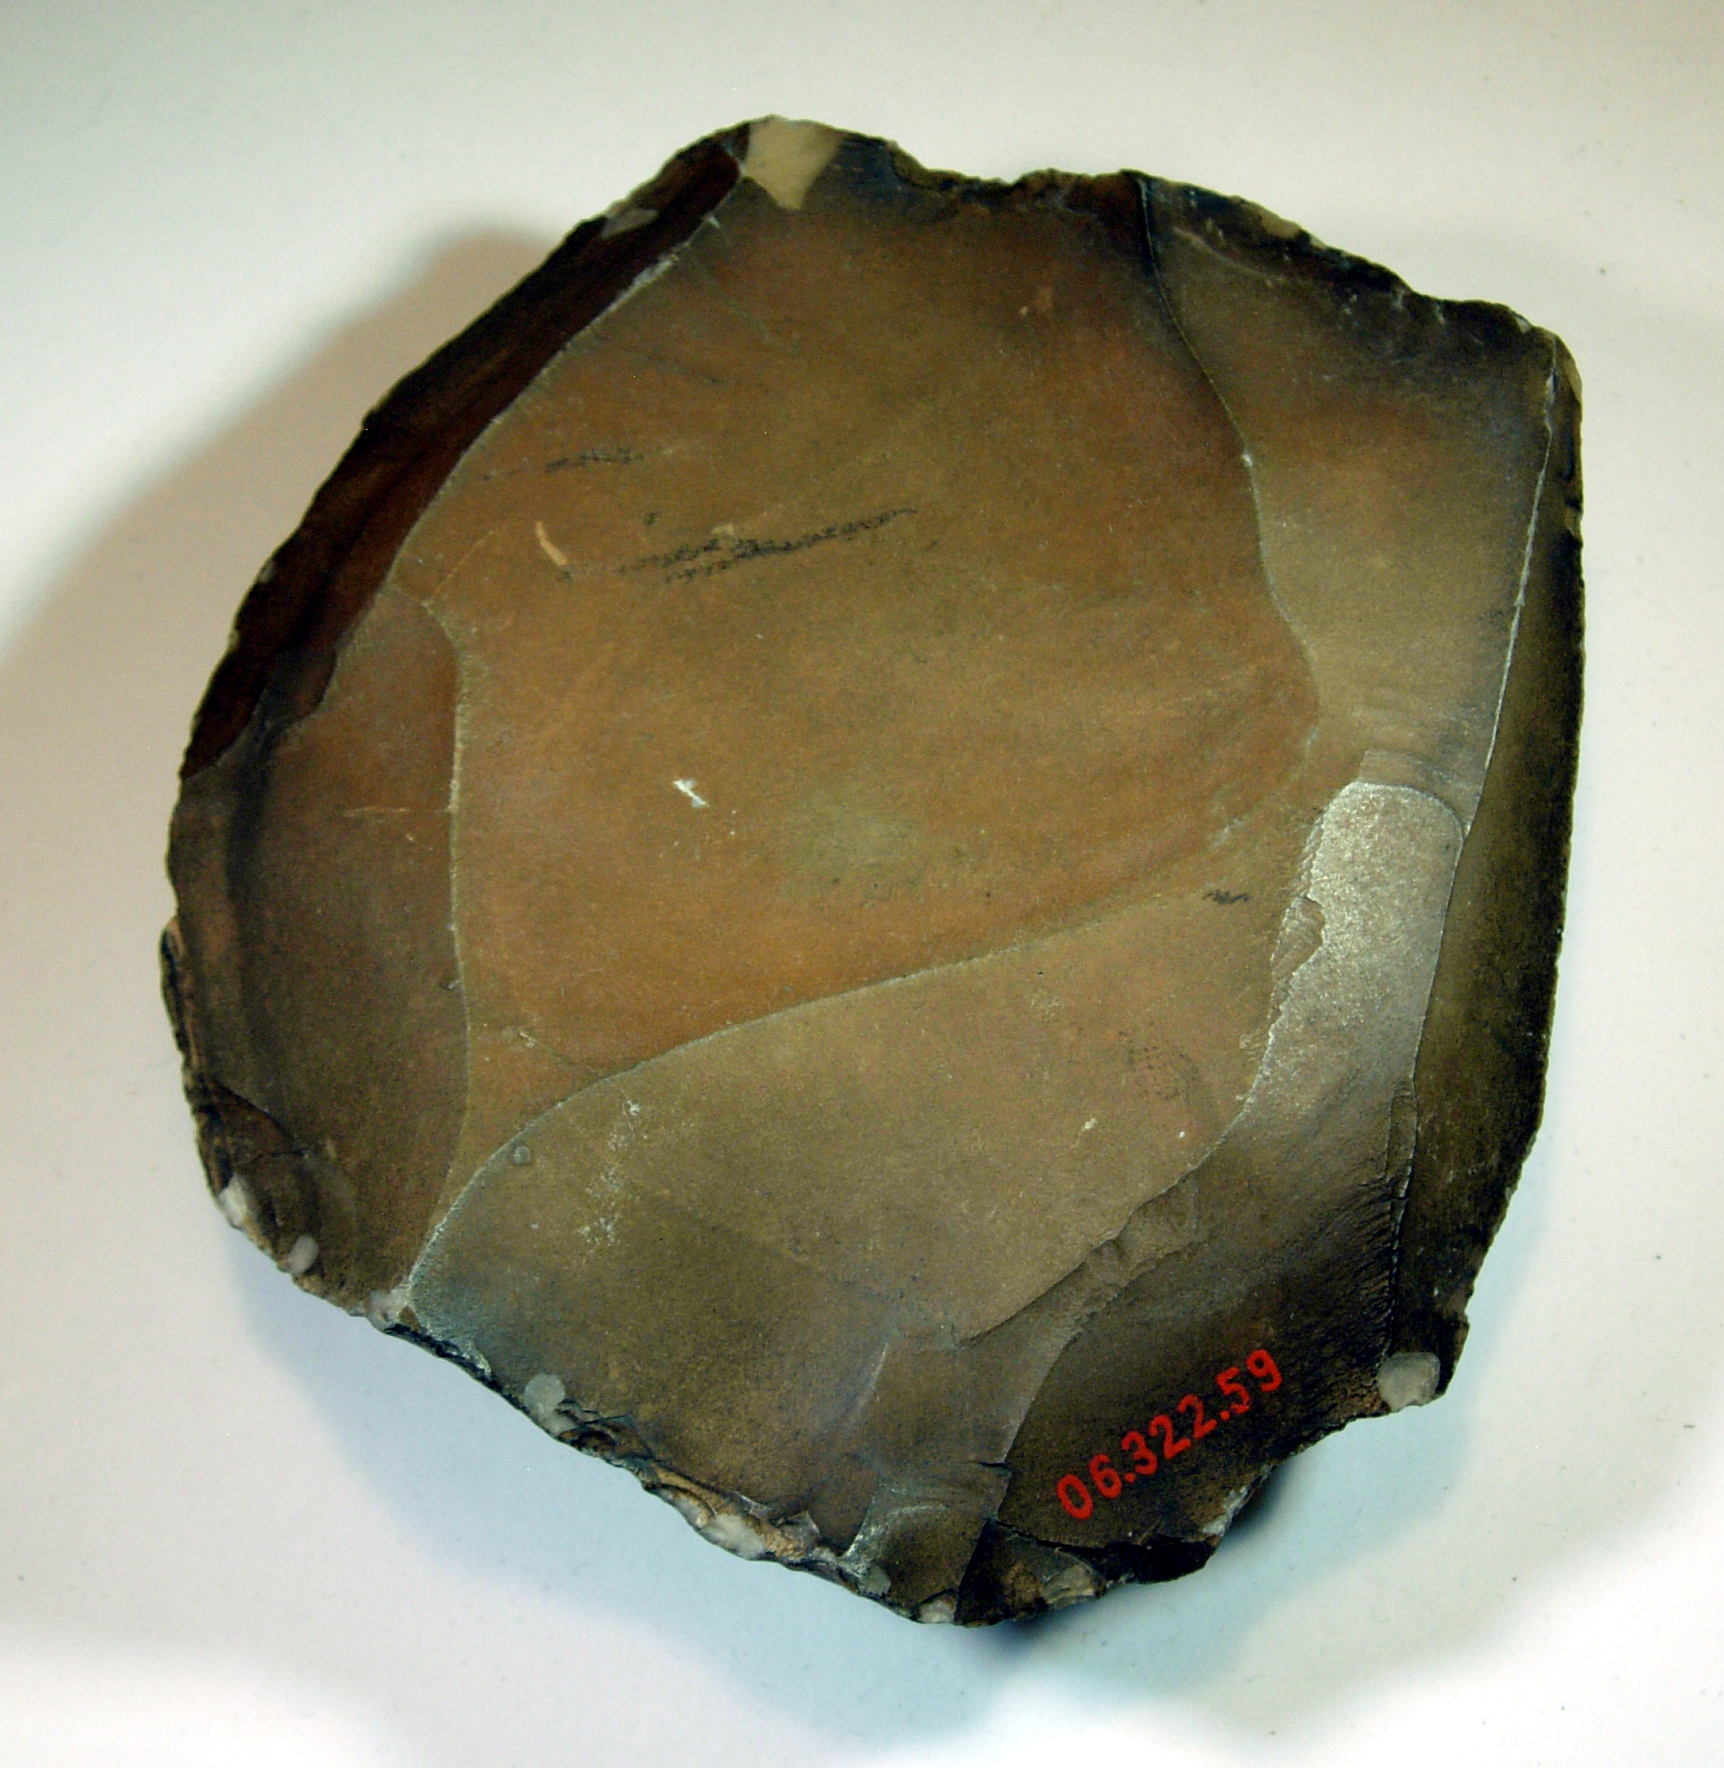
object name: core, levallois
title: Levallois Core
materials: stone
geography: egypt